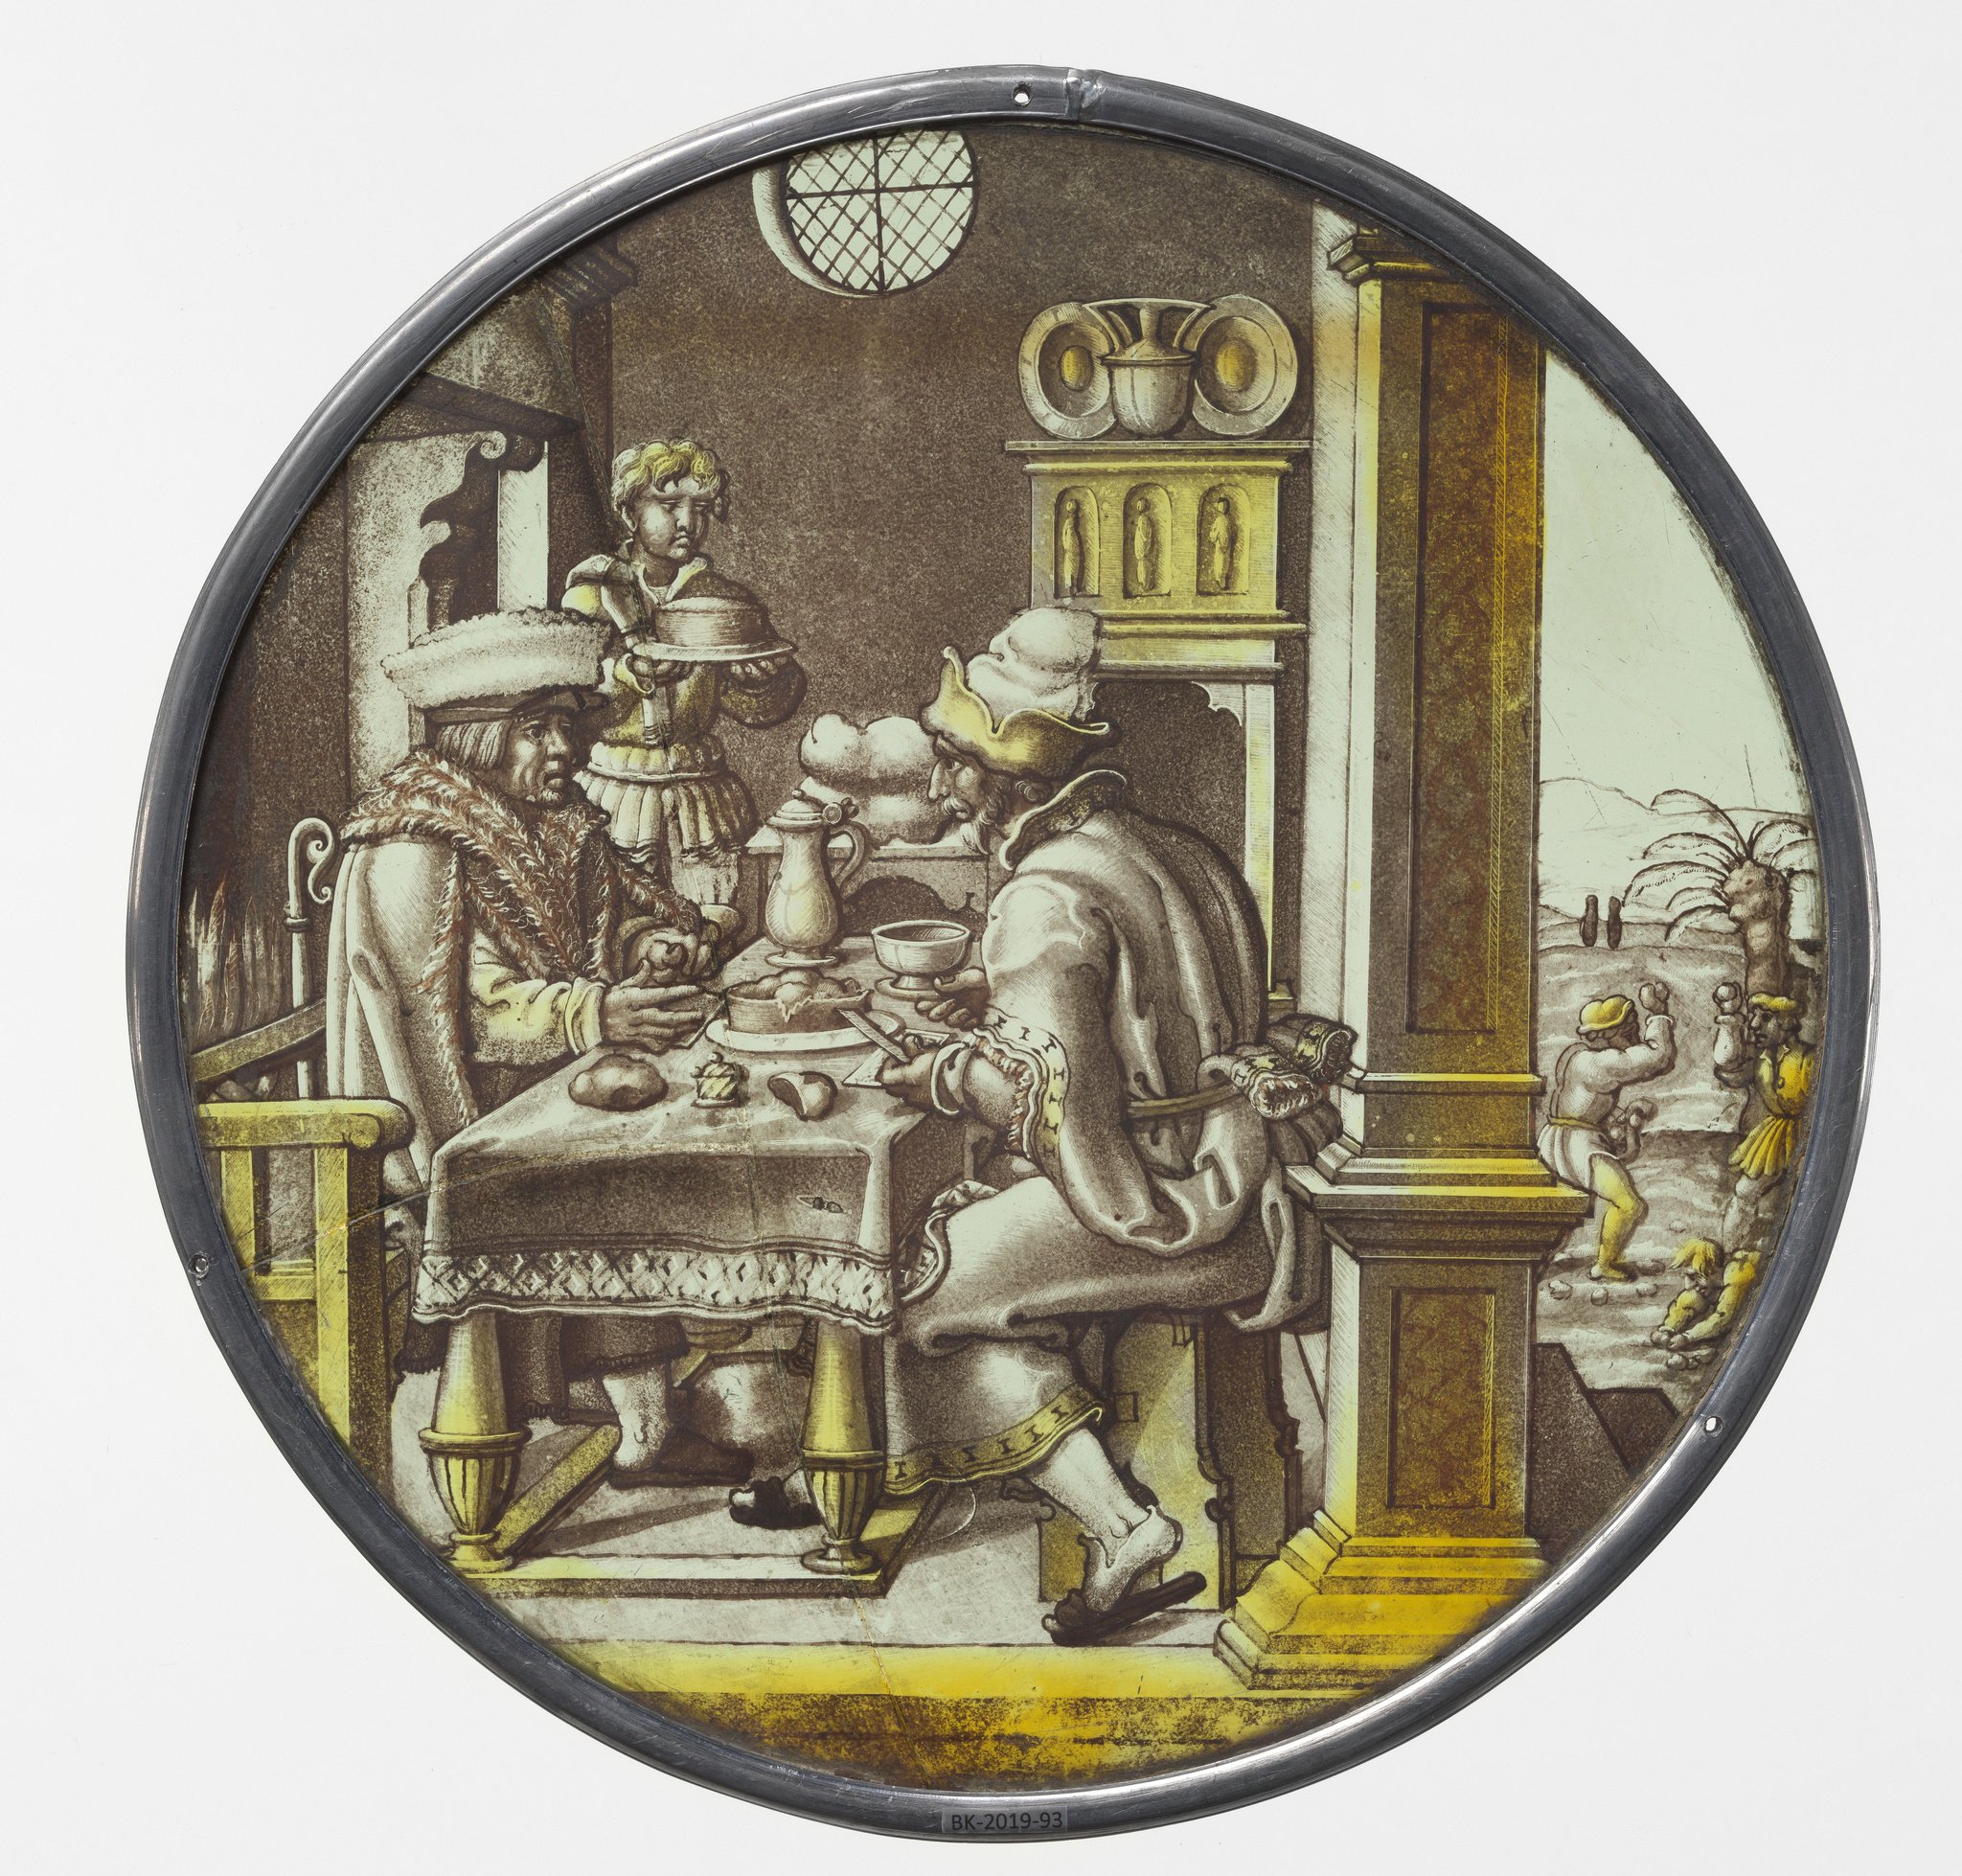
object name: light window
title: Winter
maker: Anonymous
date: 1540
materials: glass, lead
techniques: enamel painting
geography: leiden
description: Aan een rijk gedekte tafel in een 16de-eeuws interieur zitten twee mannen in bontgevoerde kleding. Op tafel met baluster poten staat een pastei, een dienaar brengt het volgende gerecht. In de open haard brandt een vuur. Op een laatmiddeleeuws buffet staat antikiserend vaatwerk. Rechts, voorbij een pilaster, is een uitkijk naar een achtergrondscène met sneeuwbalgevecht in landschap.